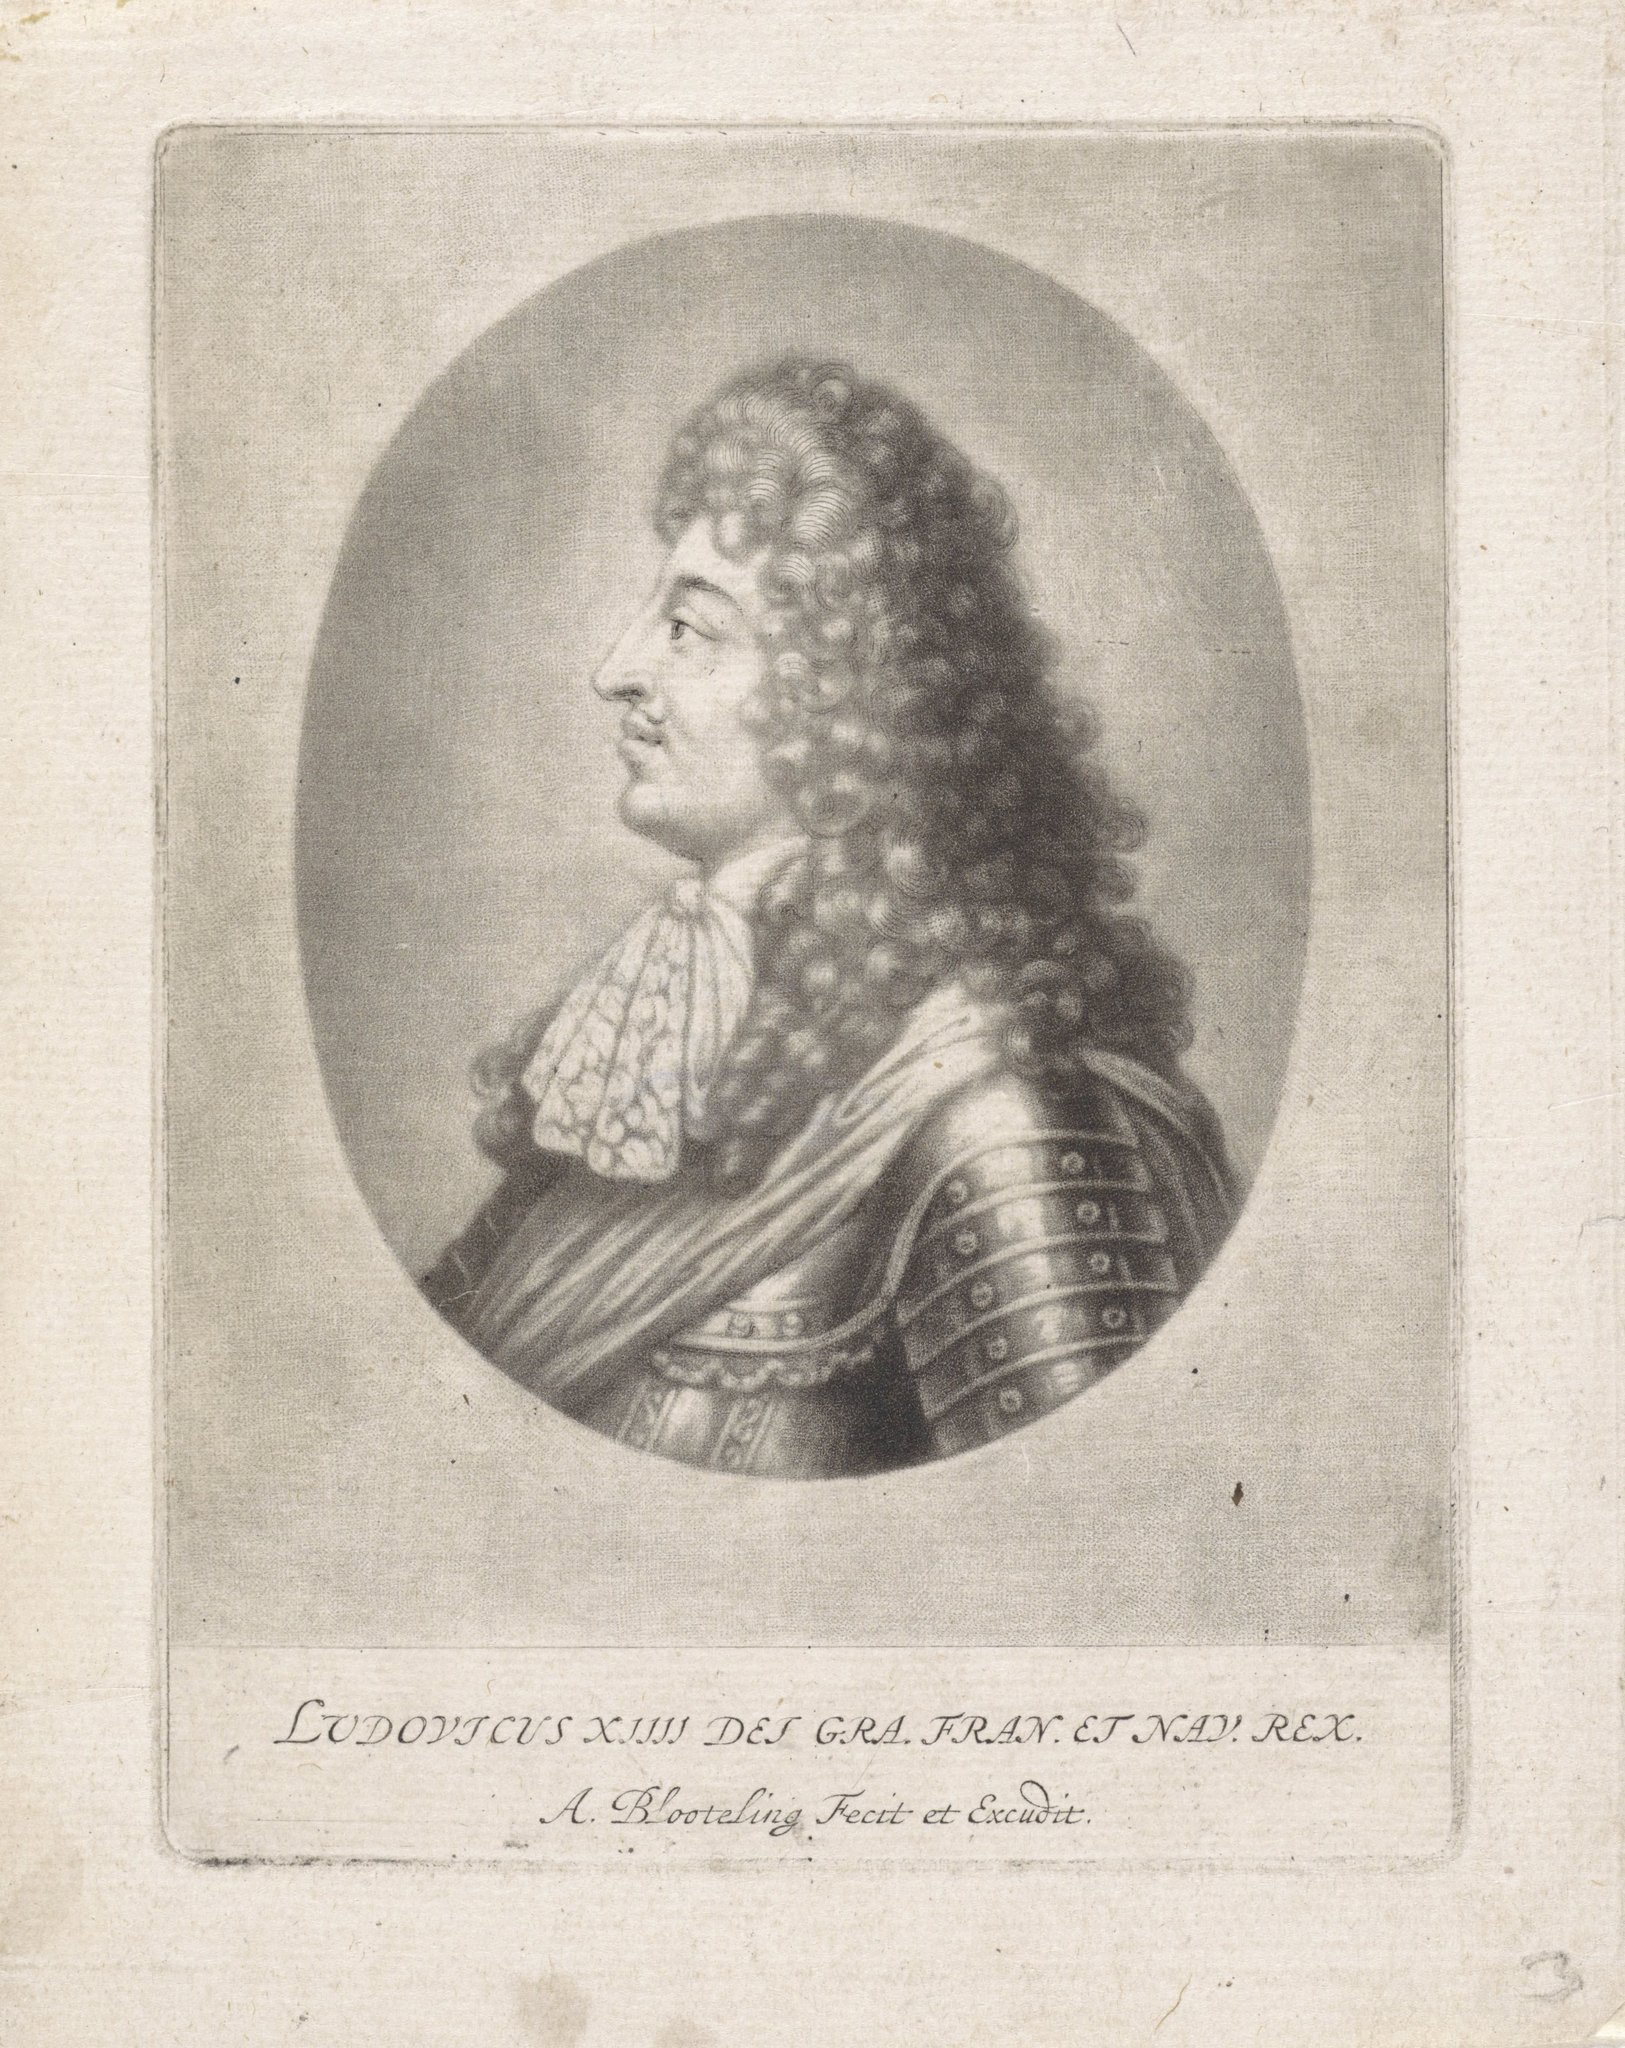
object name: print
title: Portret van Lodewijk XIV, koning van Frankrijk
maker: abraham bloteling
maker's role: draughtsman, print maker, publisher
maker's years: 1640-1690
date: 1652-1690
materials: paper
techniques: engraving, etching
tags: lodewijk xiv (koning van frankrijk), wig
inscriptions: collector's mark: Lugt 2228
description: Portret van Lodewijk XIV, koning van Frankrijk, in een harnas met kanten kraag en een lange krulpruik. De prent heeft een Latijns onderschrift met de naam en de titels van de geportretteerde.